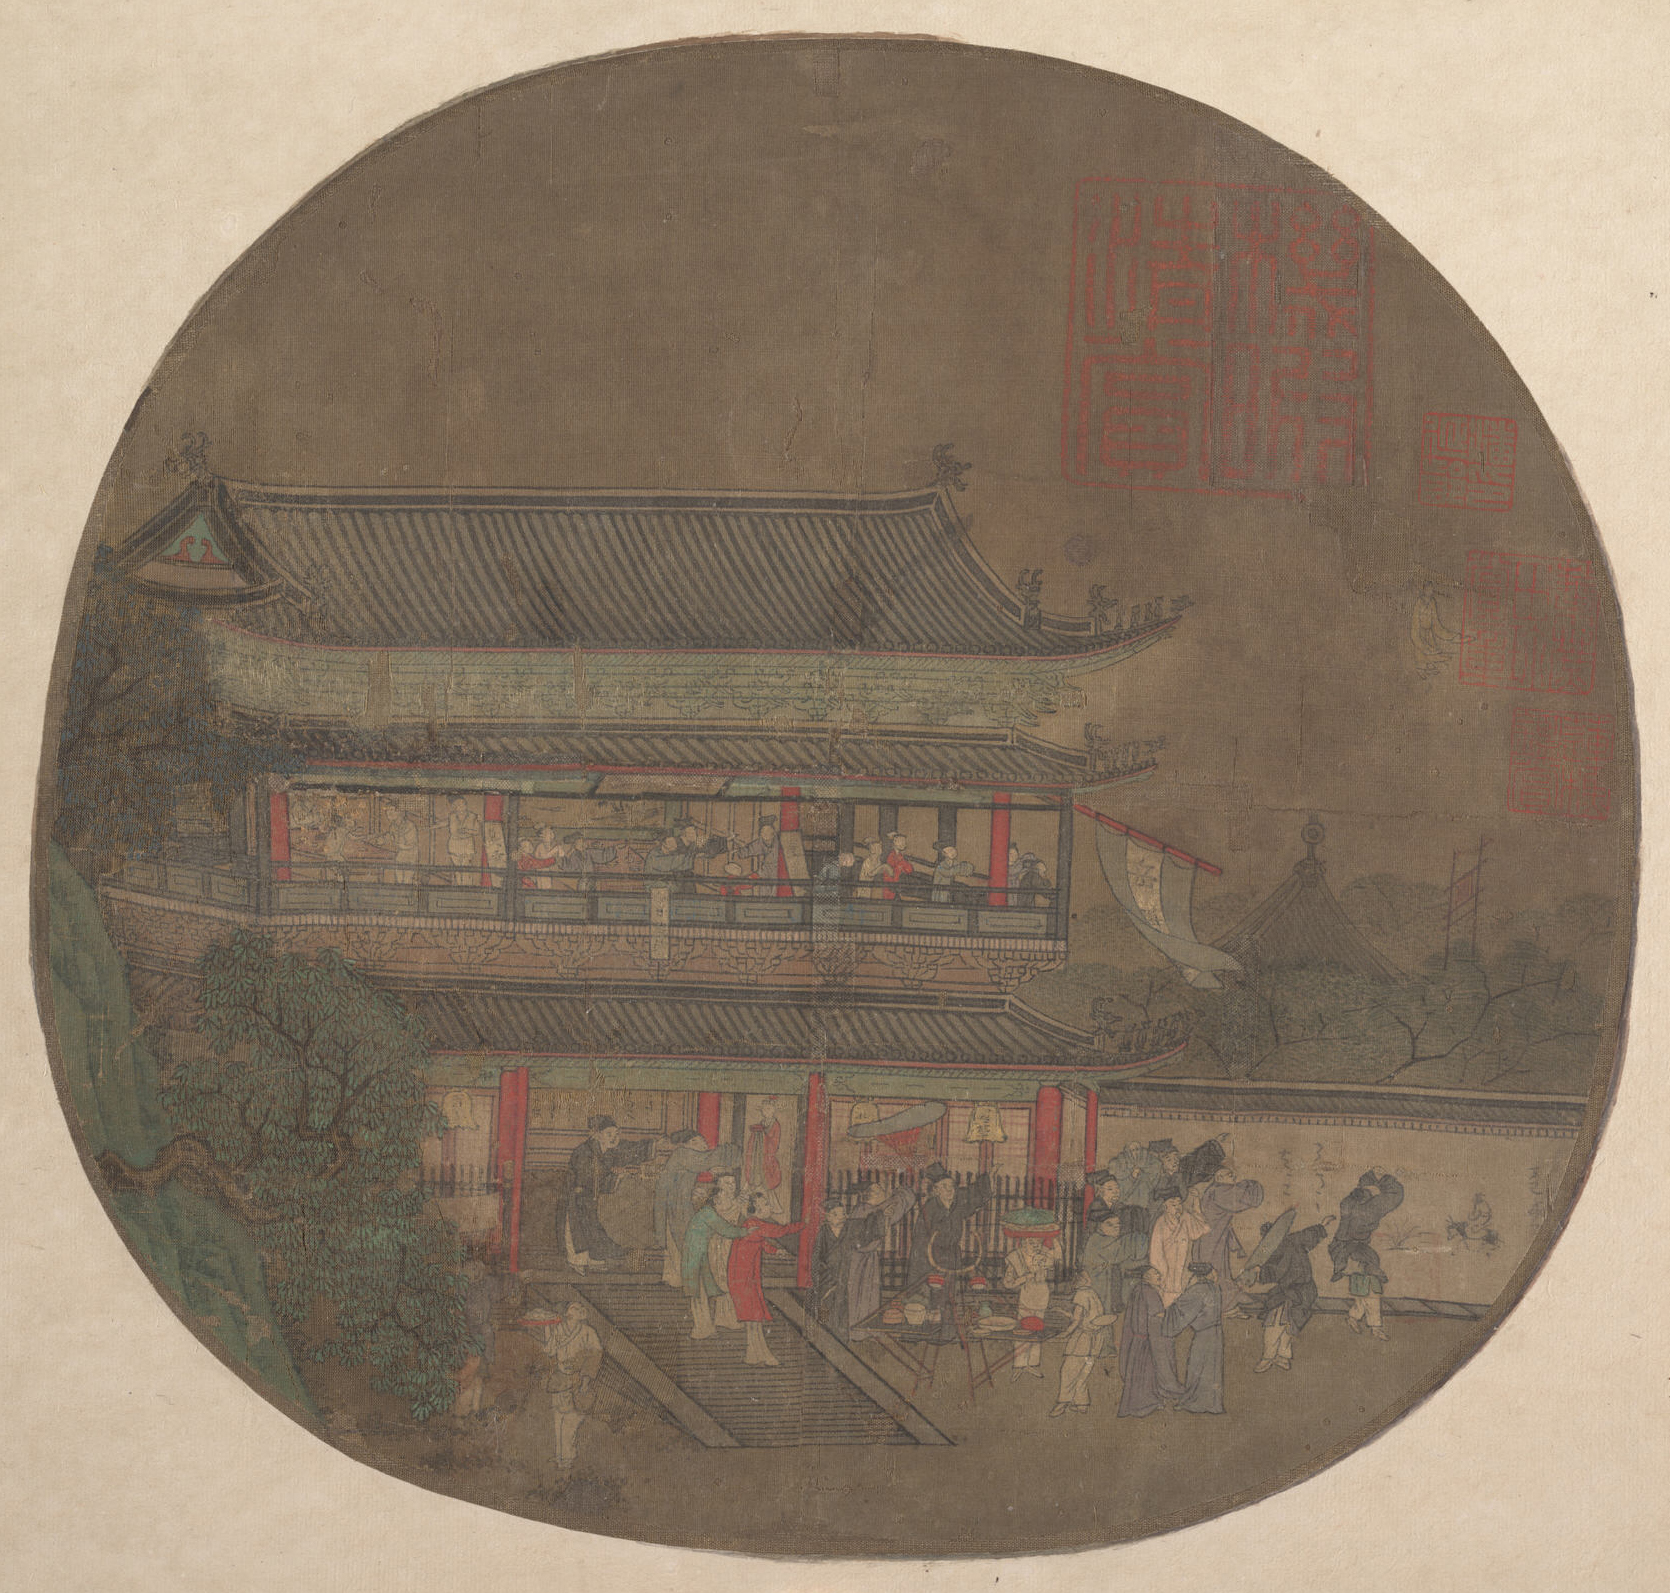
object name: fan mounted a an album leaf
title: The Immortal Lü Dongbin Appearing over the Yueyang Pavilion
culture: chinese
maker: unidentified artist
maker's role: artist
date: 1267-1333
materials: ink, silk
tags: men,pavilions